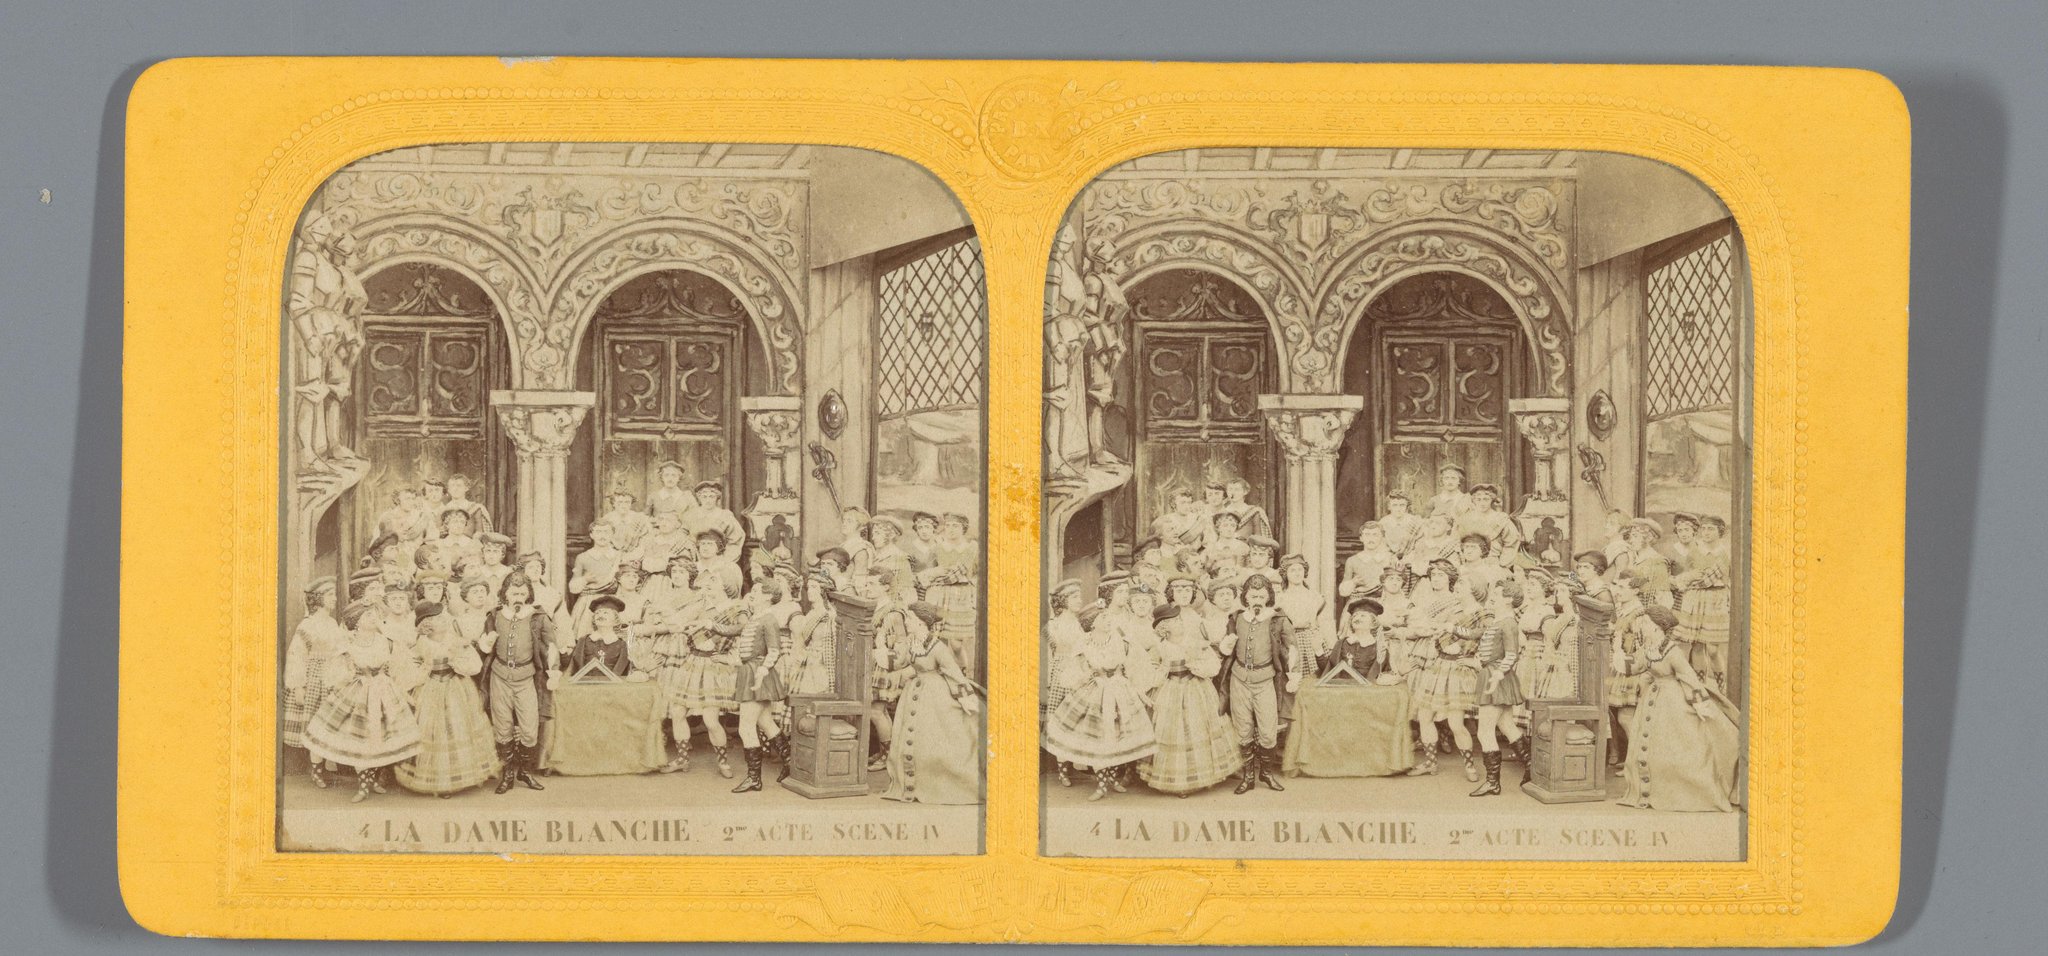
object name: stereograph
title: Stereofoto van het theater in Parijs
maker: Anonymous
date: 1867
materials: cardboard, photographic support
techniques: albumen print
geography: paris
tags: group of actors, troupe; actors on the stage, paris